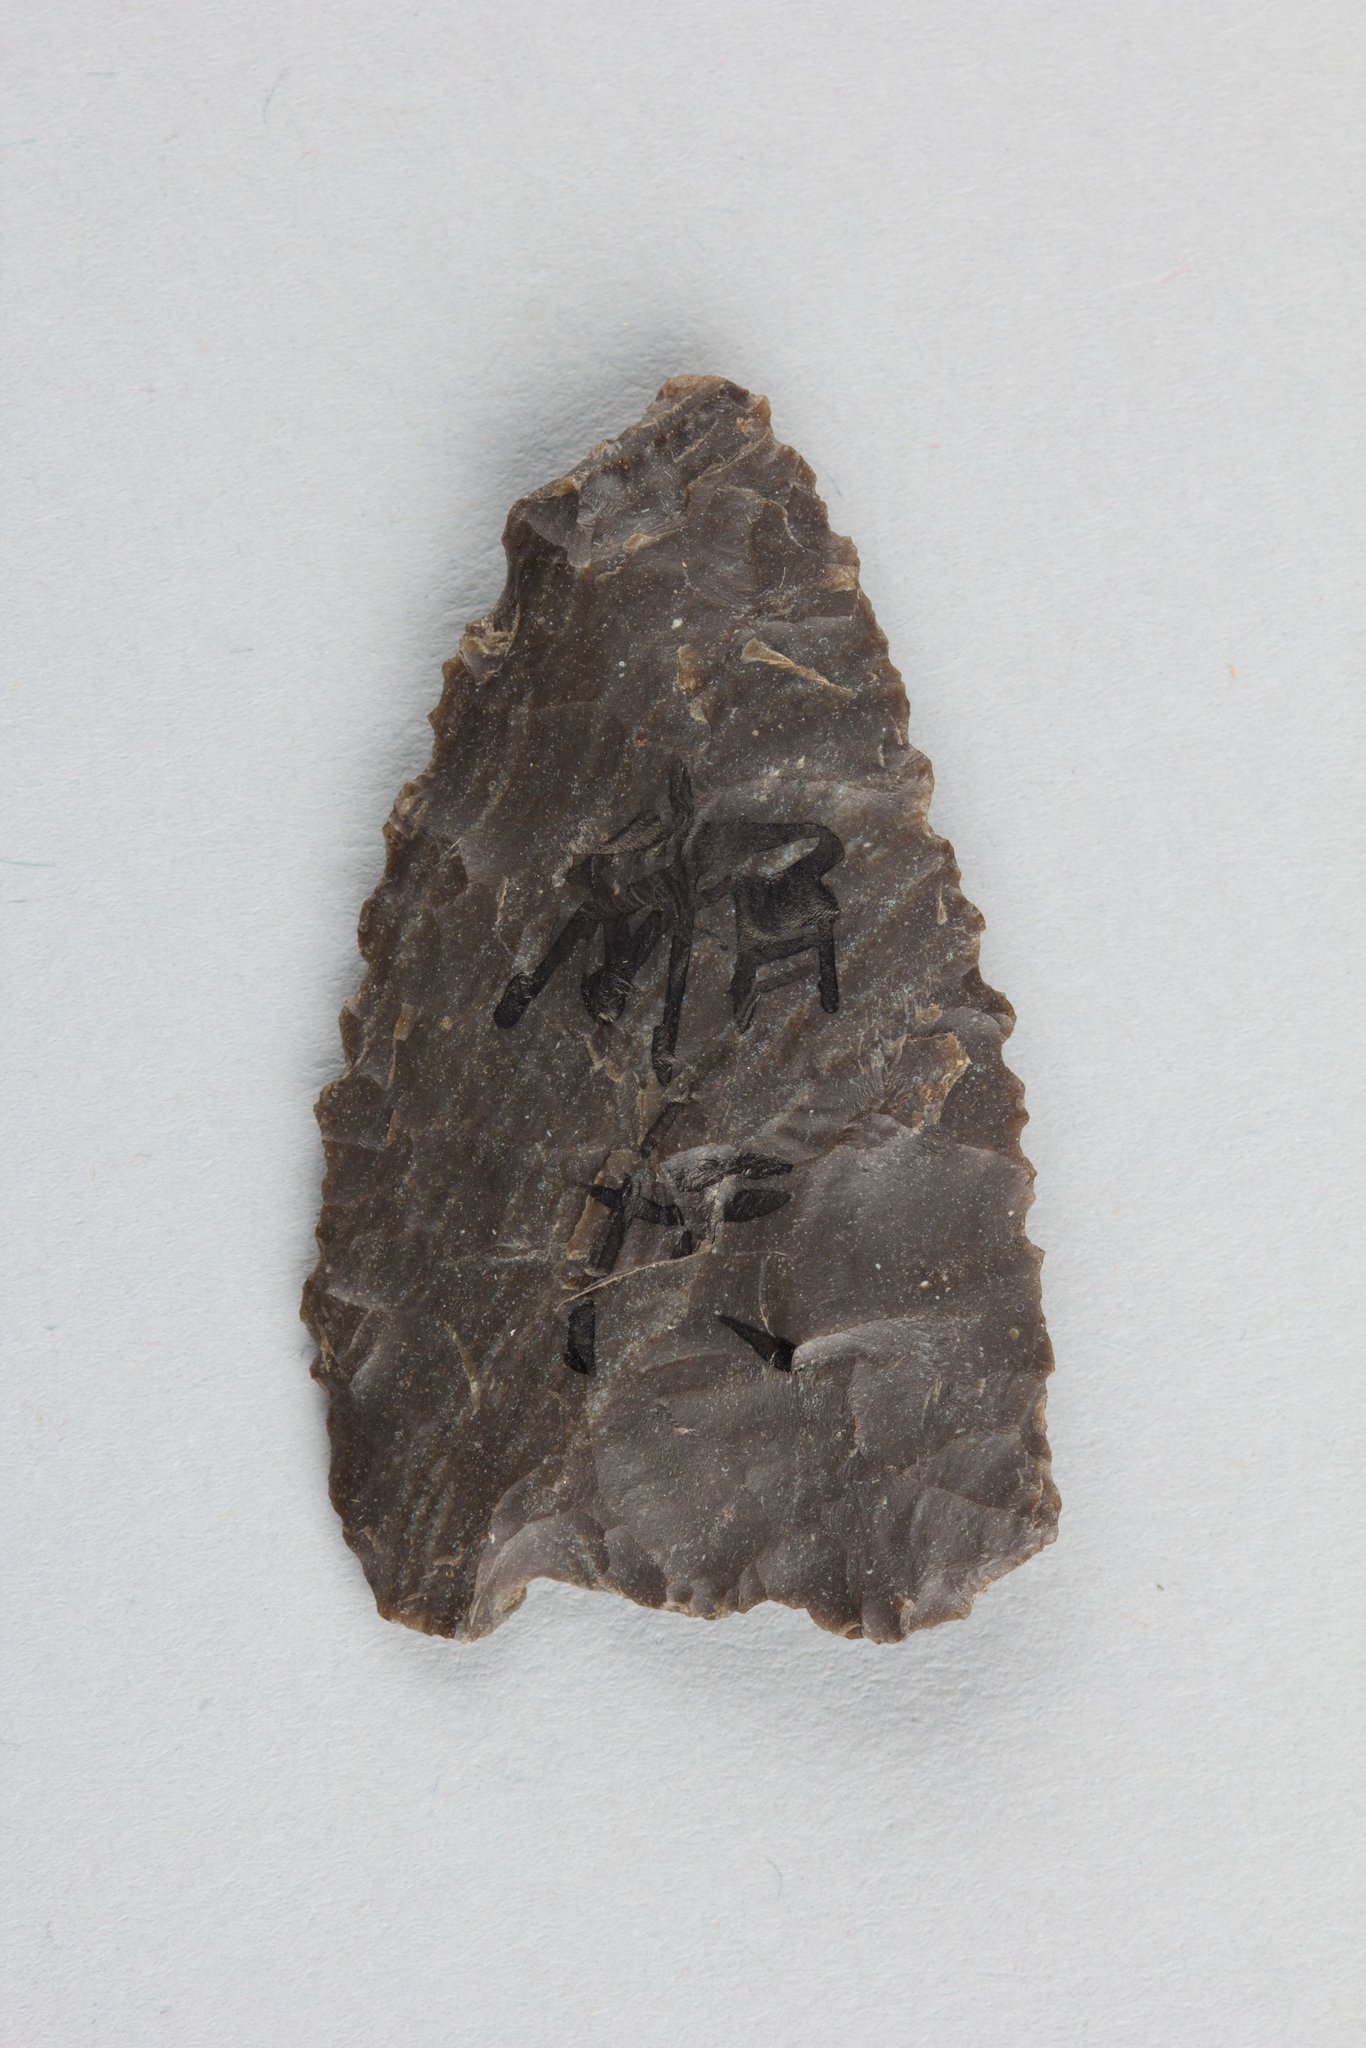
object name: arrowhead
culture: japanese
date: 1500-1000 BCE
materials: stone